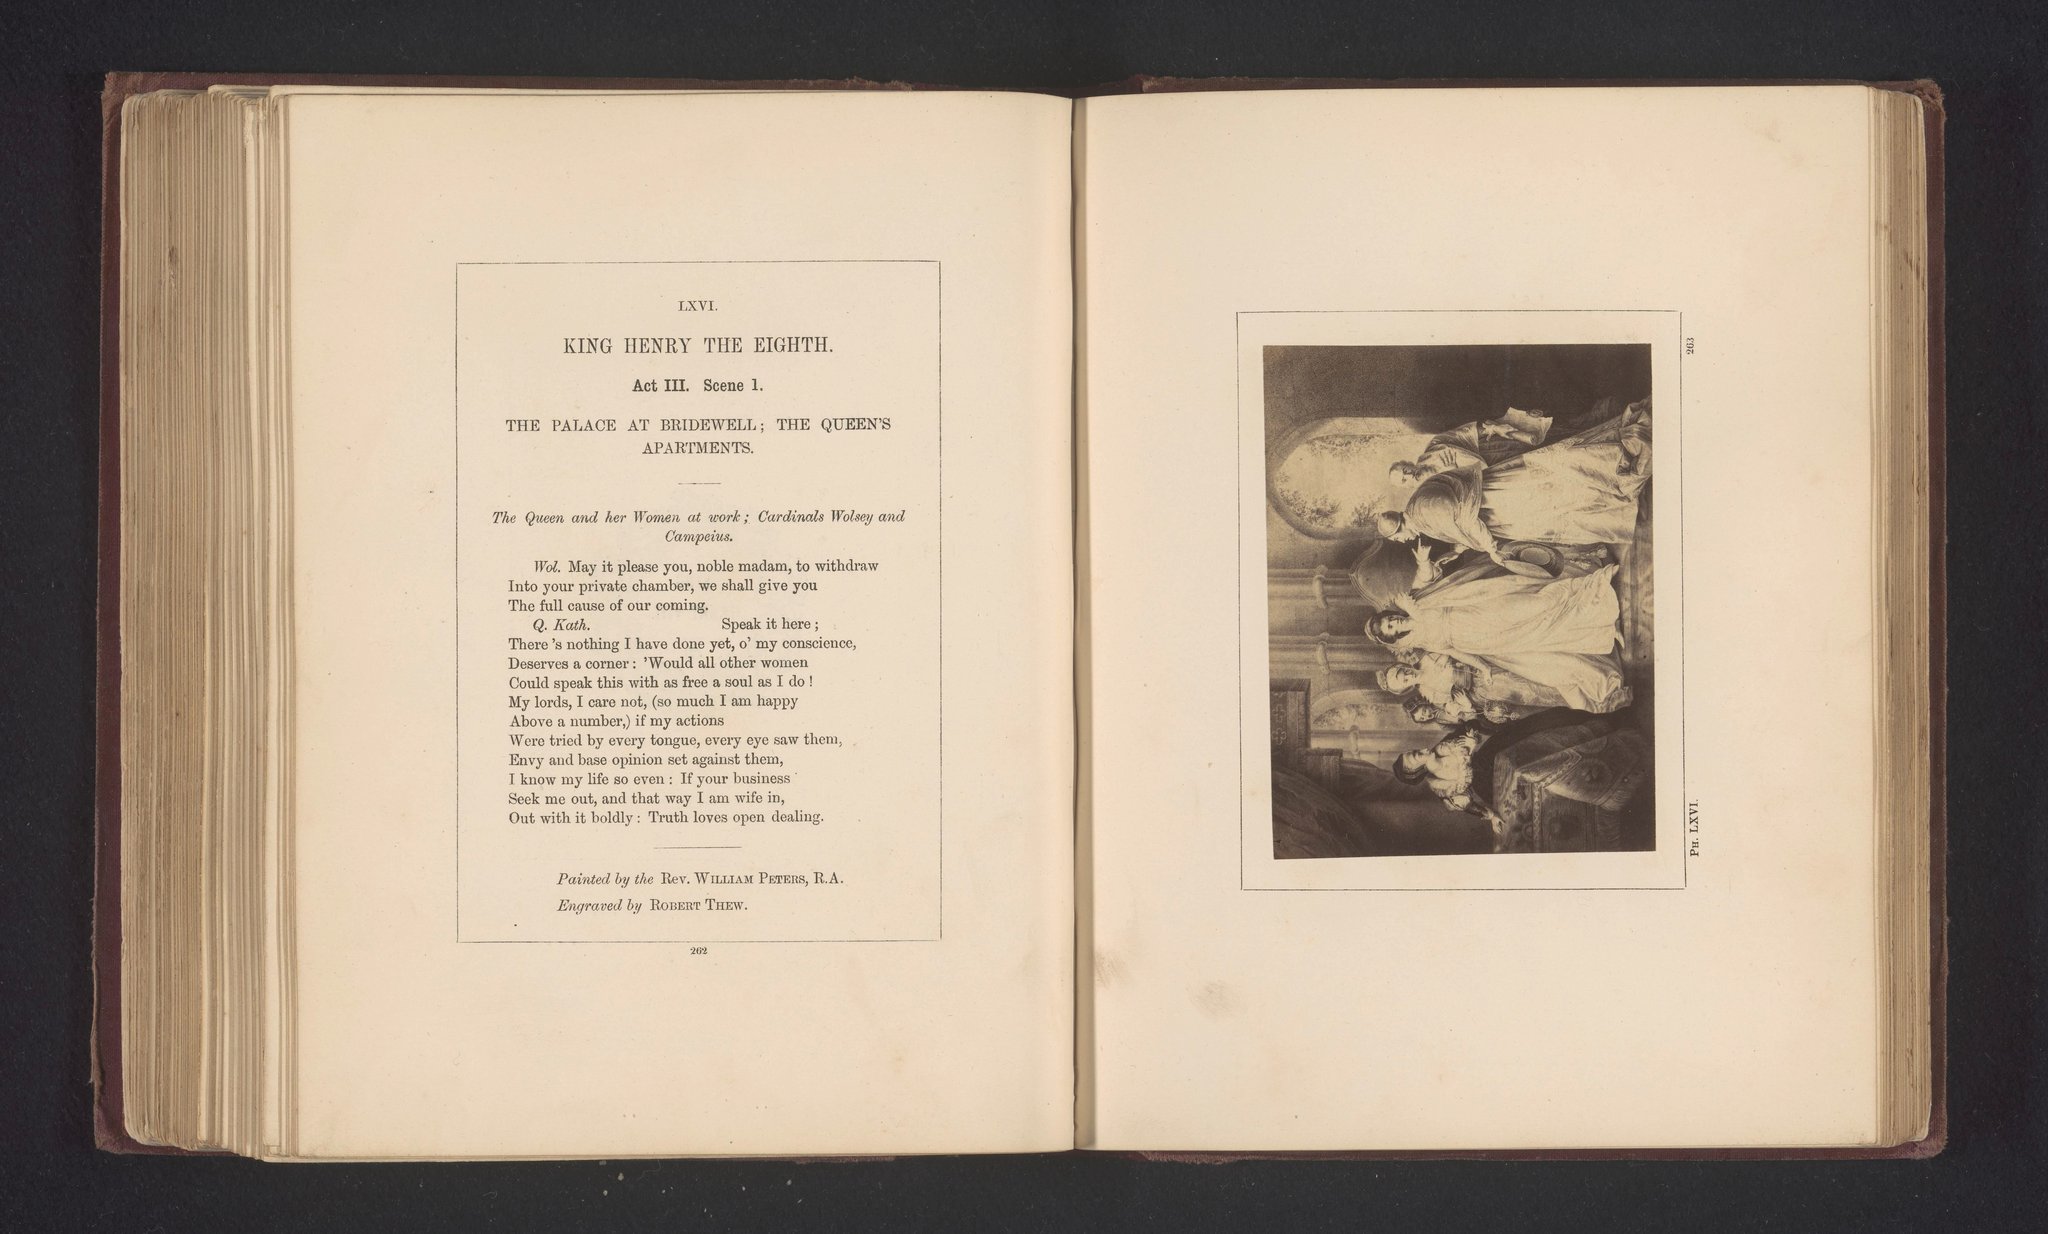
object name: page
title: Fotoreproductie van een prent naar een schilderij door Matthew William Peters, voorstellend een scene uit Hendrik VIII door William Shakespeare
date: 1854-1867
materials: photographic support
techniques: albumen print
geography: london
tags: specific works of literature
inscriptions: number: ‘Ph. LXVI. 263’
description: Te zien is akte III, scene 1 met koningin Katherine en kardinaal Thomas Wolsey.